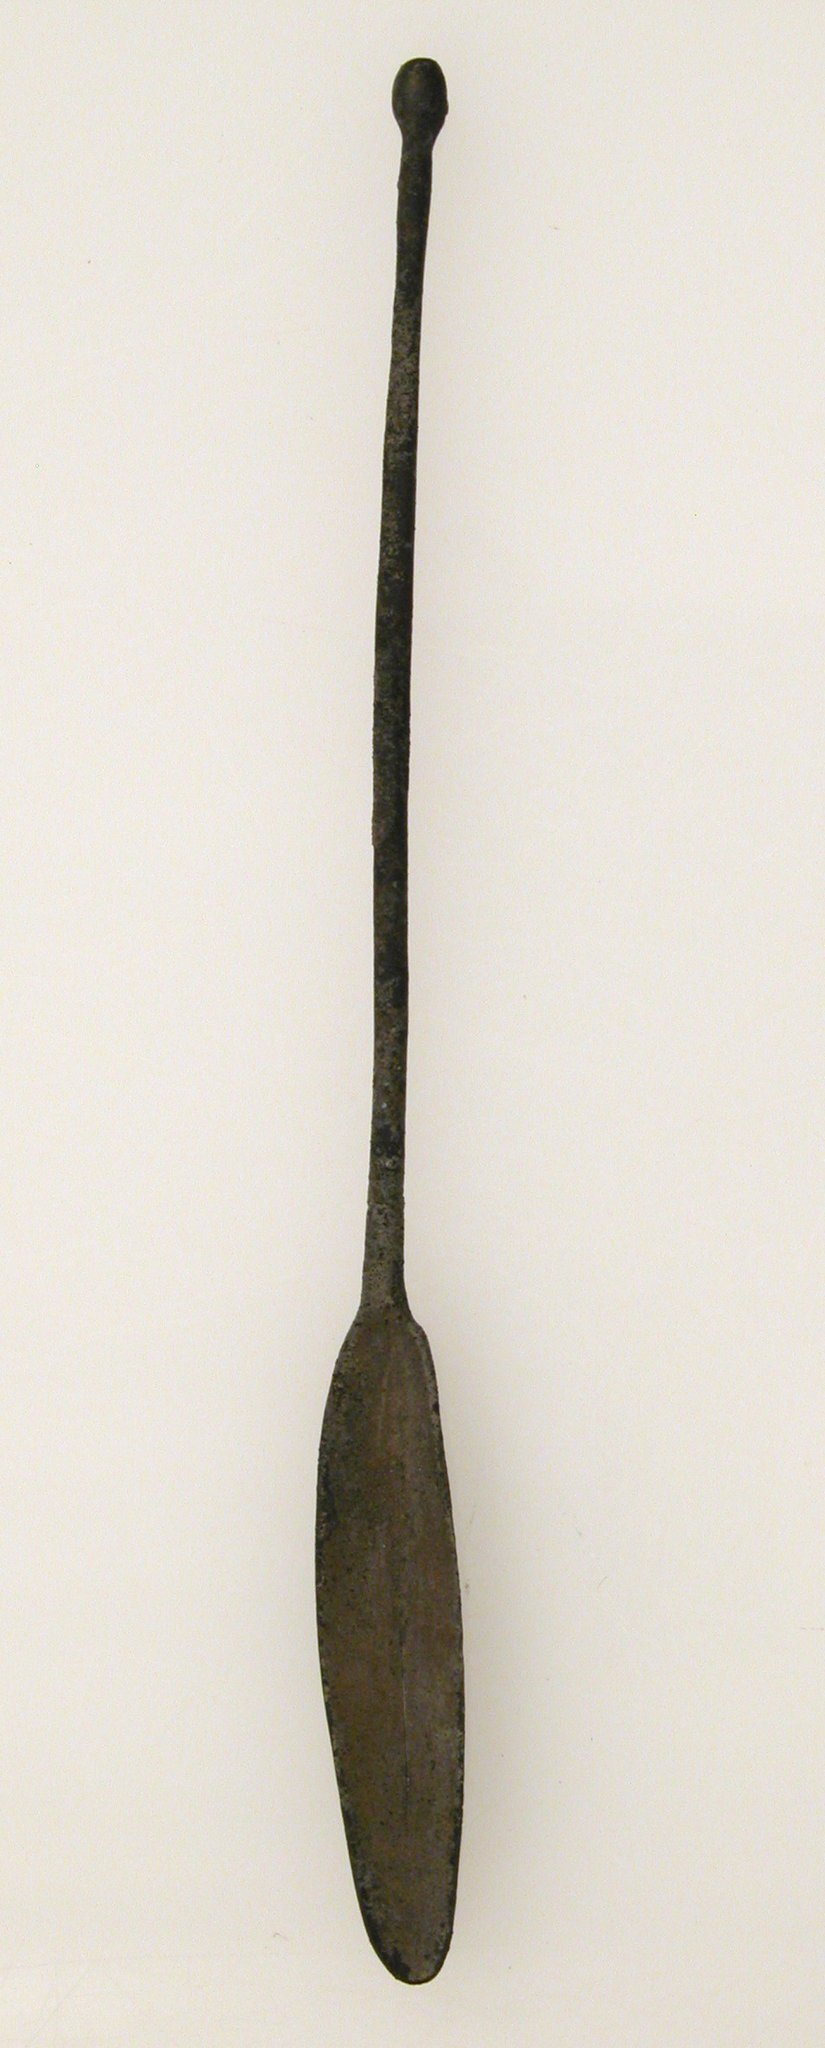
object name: spoon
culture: coptic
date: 580-640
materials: bronze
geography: egypt